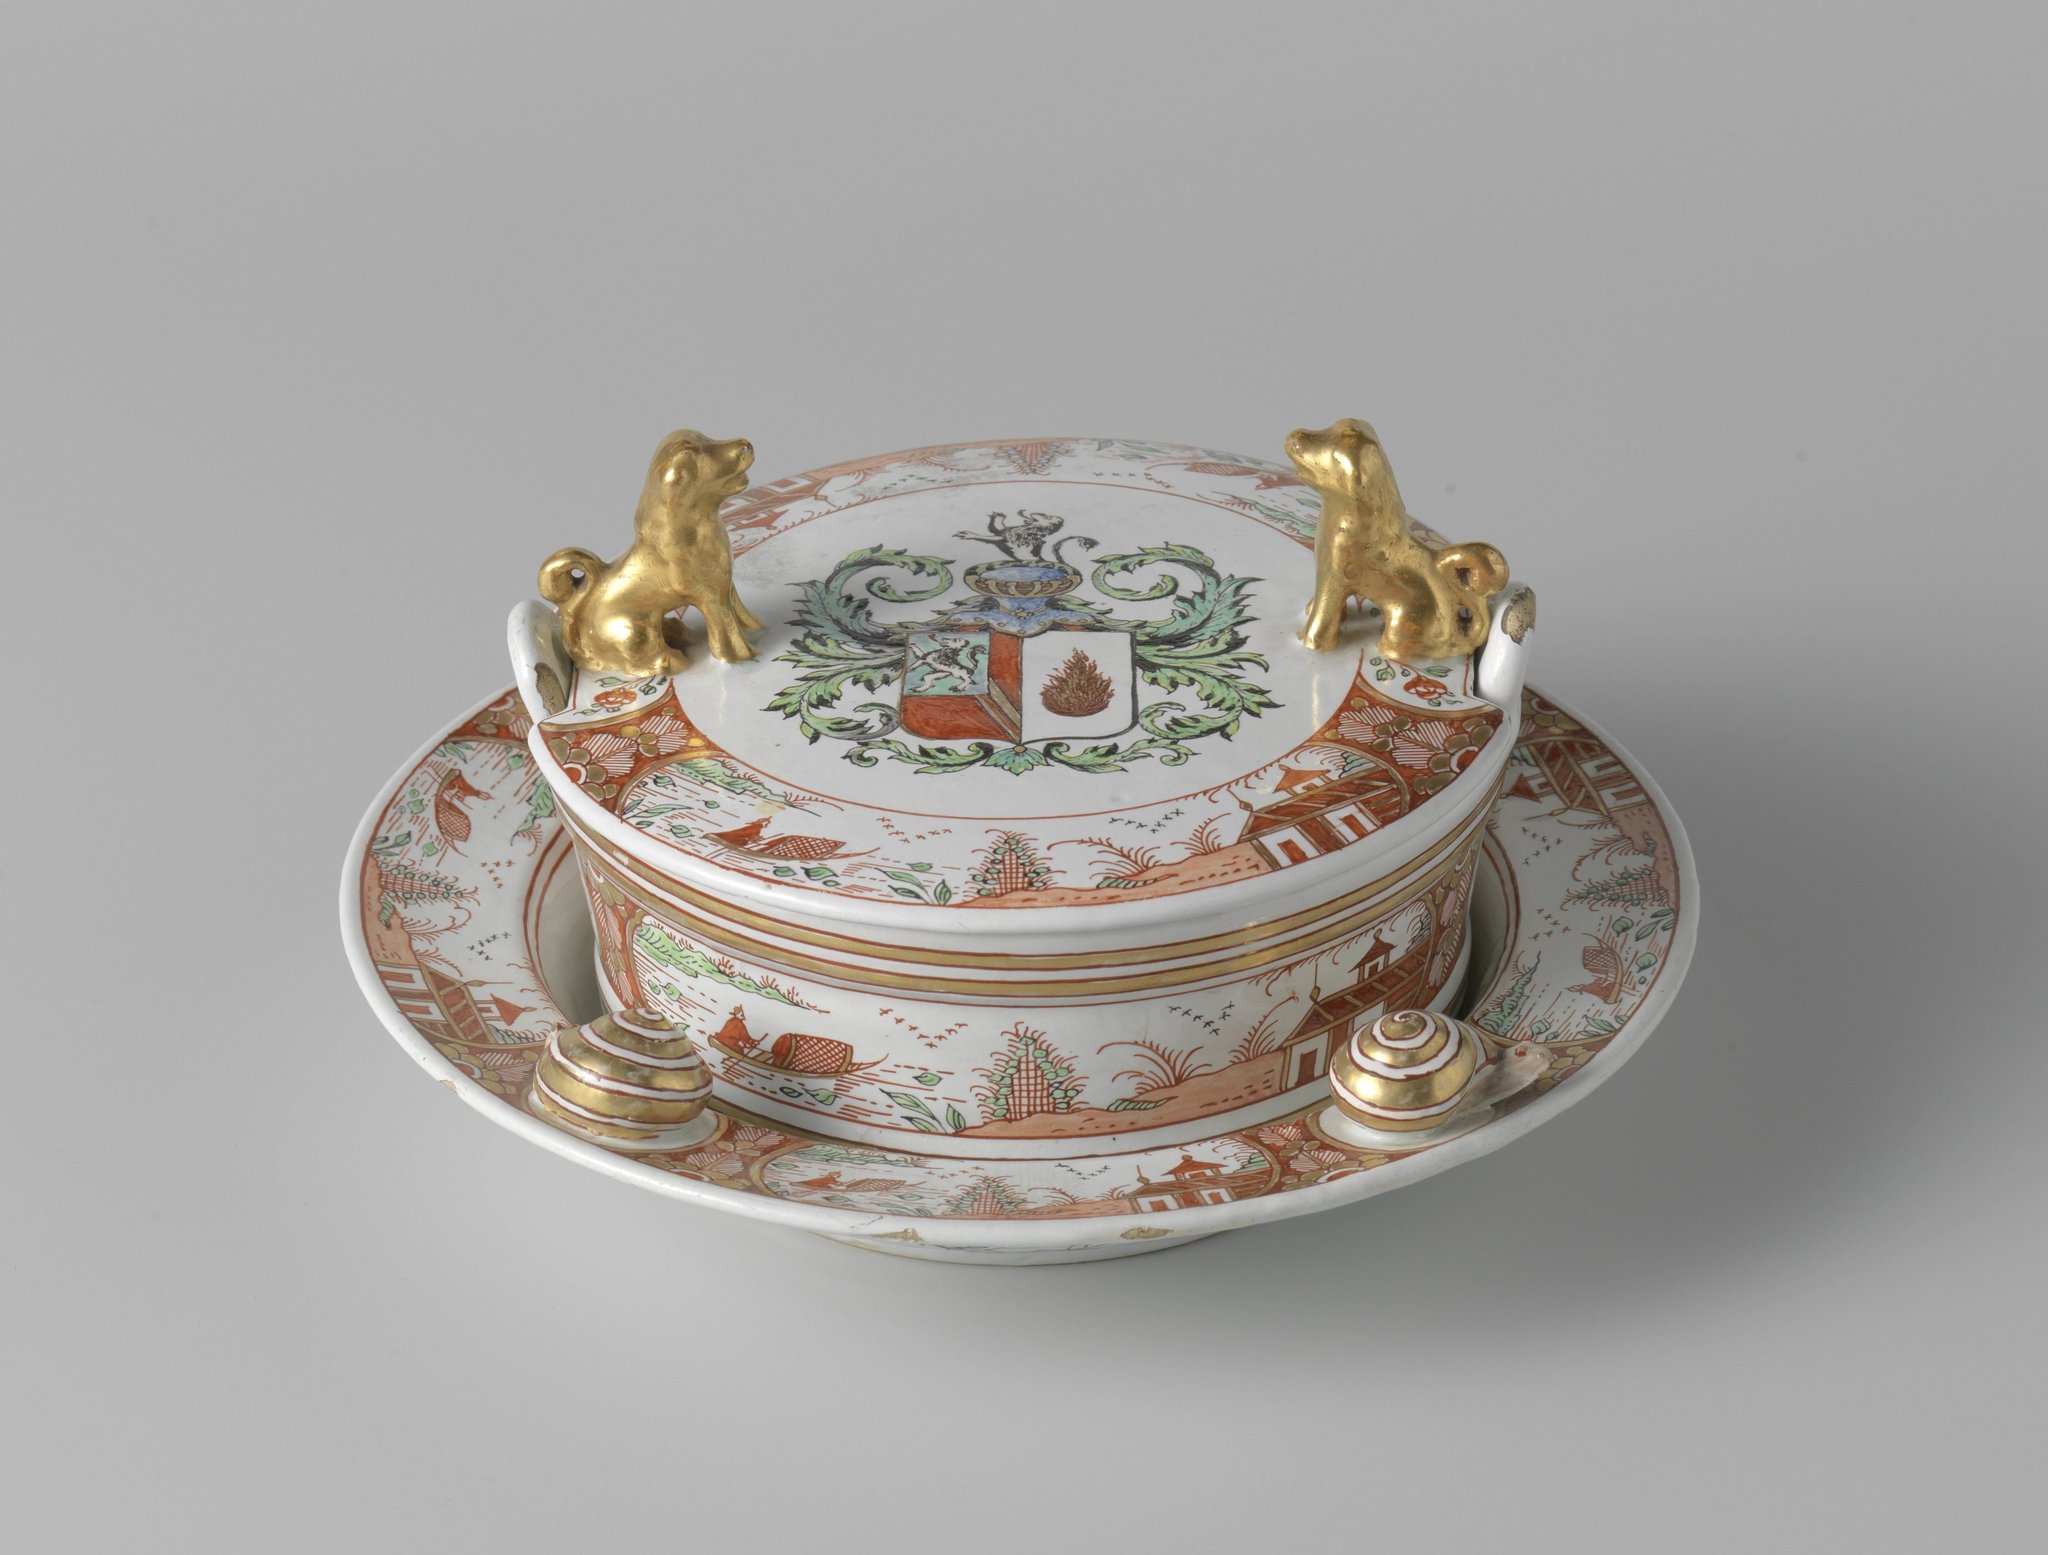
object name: platter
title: Botervloot op onderschotel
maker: Anonymous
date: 1740-1765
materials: faience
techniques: kiln, painted, polychromy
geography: delft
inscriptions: inscription: ‘2’, inscription: ‘2’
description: Butter dish and stand with the arms of the Josselet family. Faience. Delft, c. 1740 - 1765.